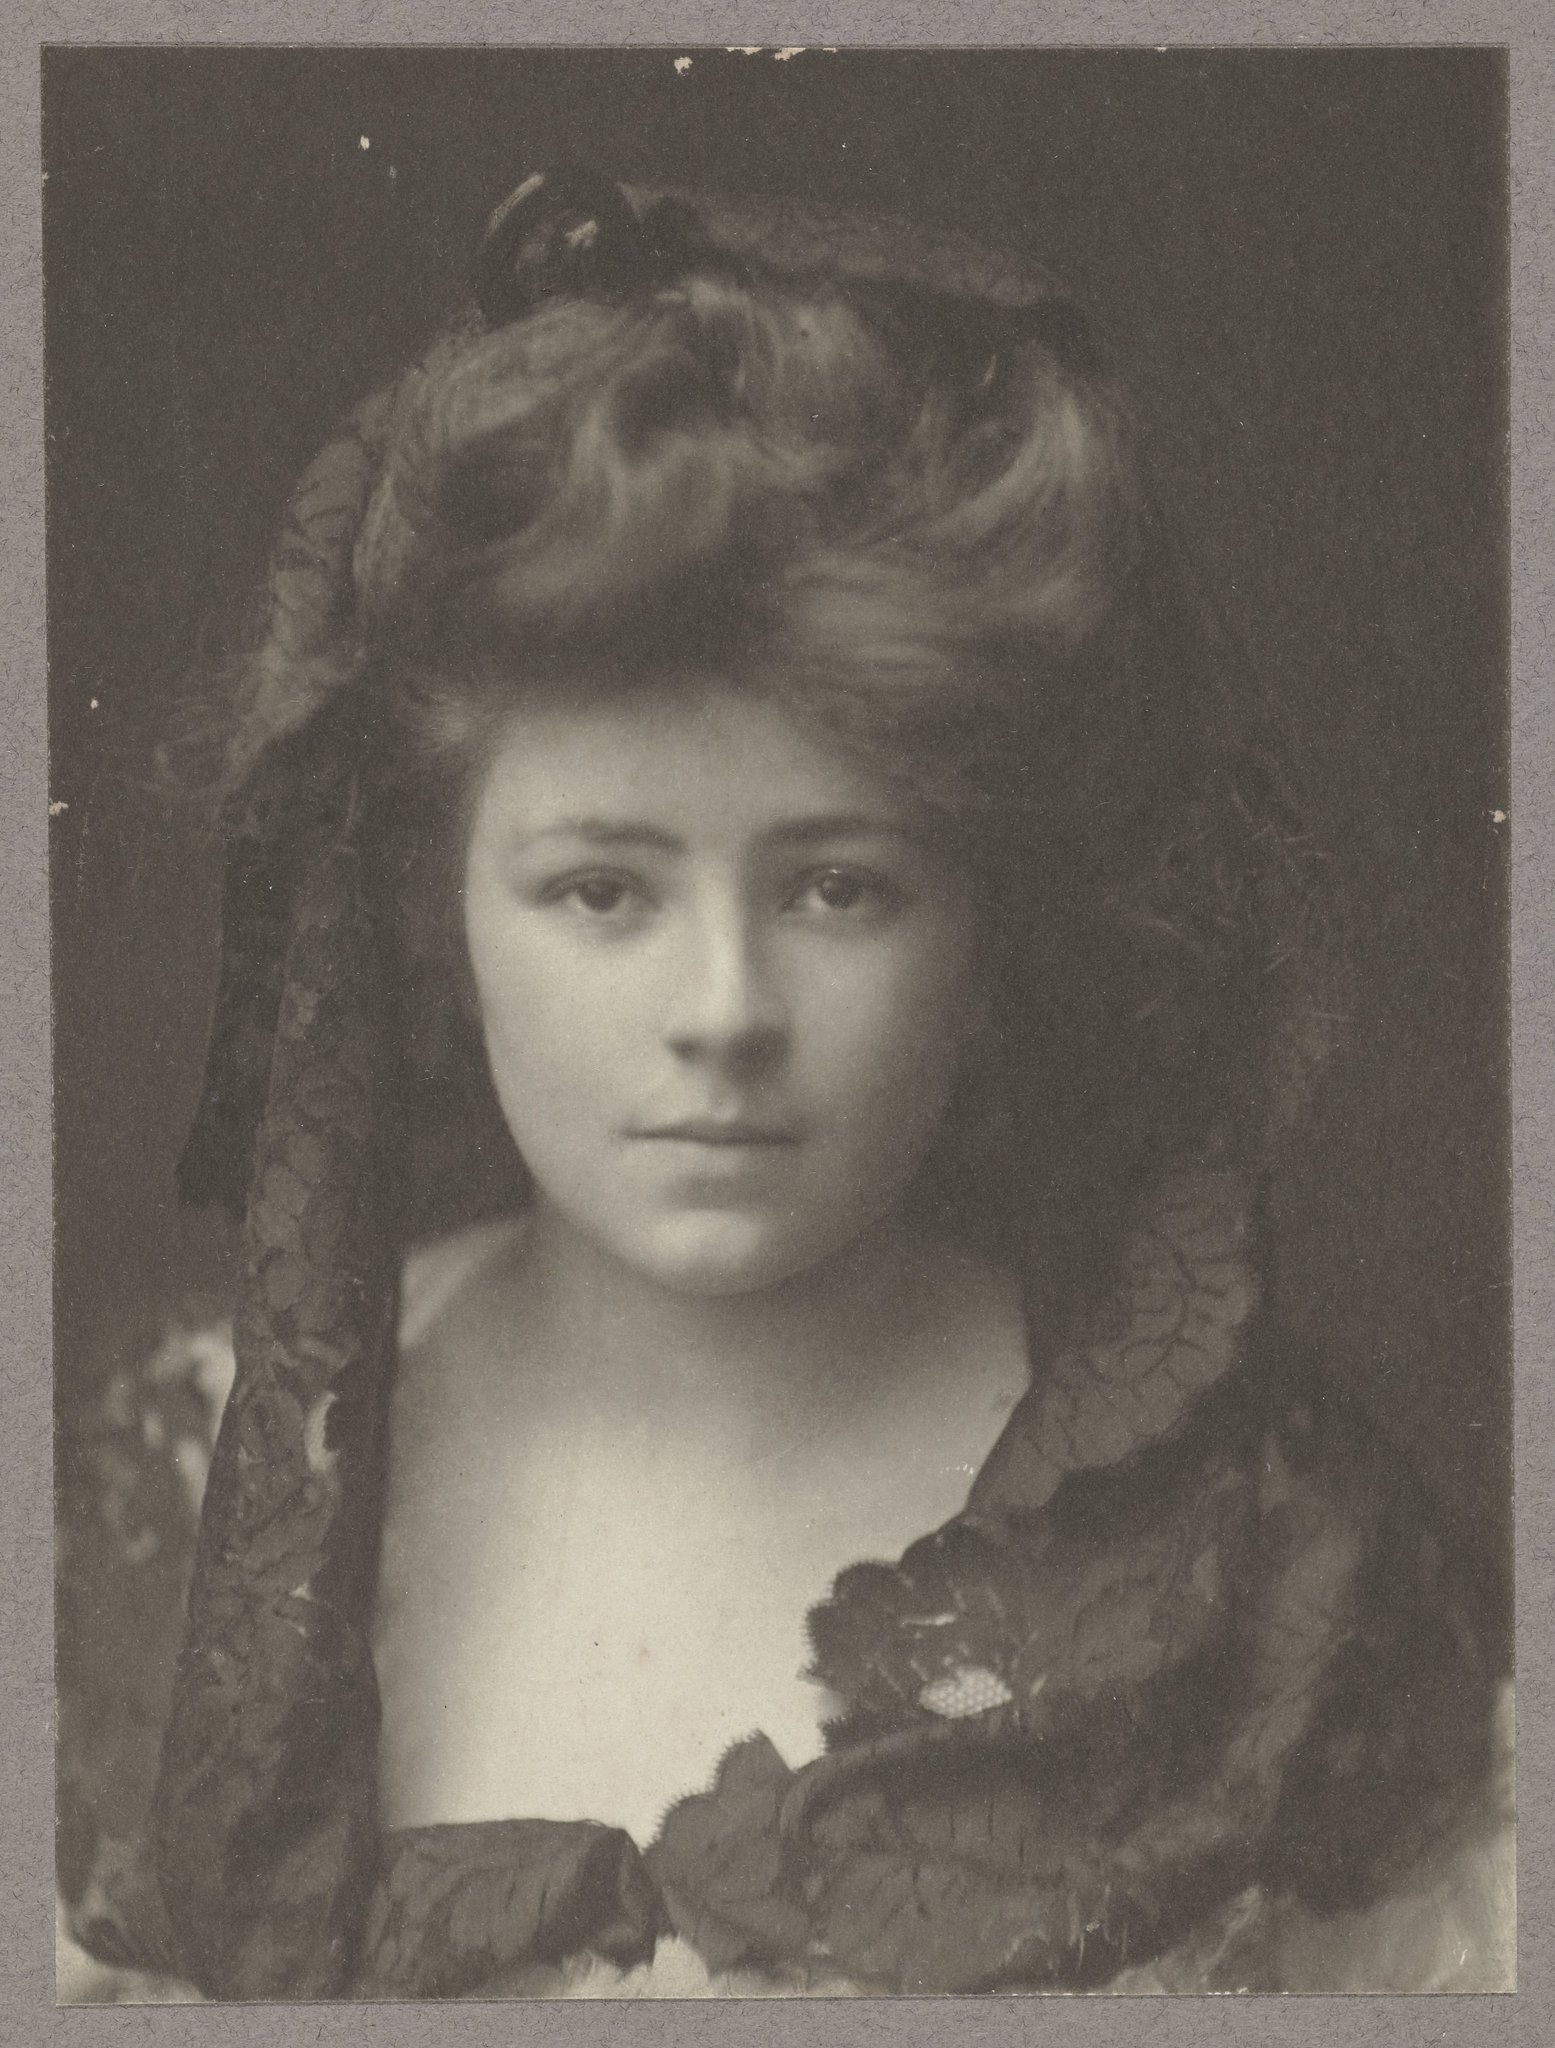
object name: photograph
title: Portret van een onbekende jonge vrouw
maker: m. shadwell clerke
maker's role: fotograaf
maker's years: 1868-1923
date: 1900-1914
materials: cardboard, photographic support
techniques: platinum process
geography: england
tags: adolescent, young woman, maiden, anonymous historical person portrayed, london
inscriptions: inscription: ‘M. SHEDWELL CLERKE/ 117,/ EBURY'S/ S.W.’